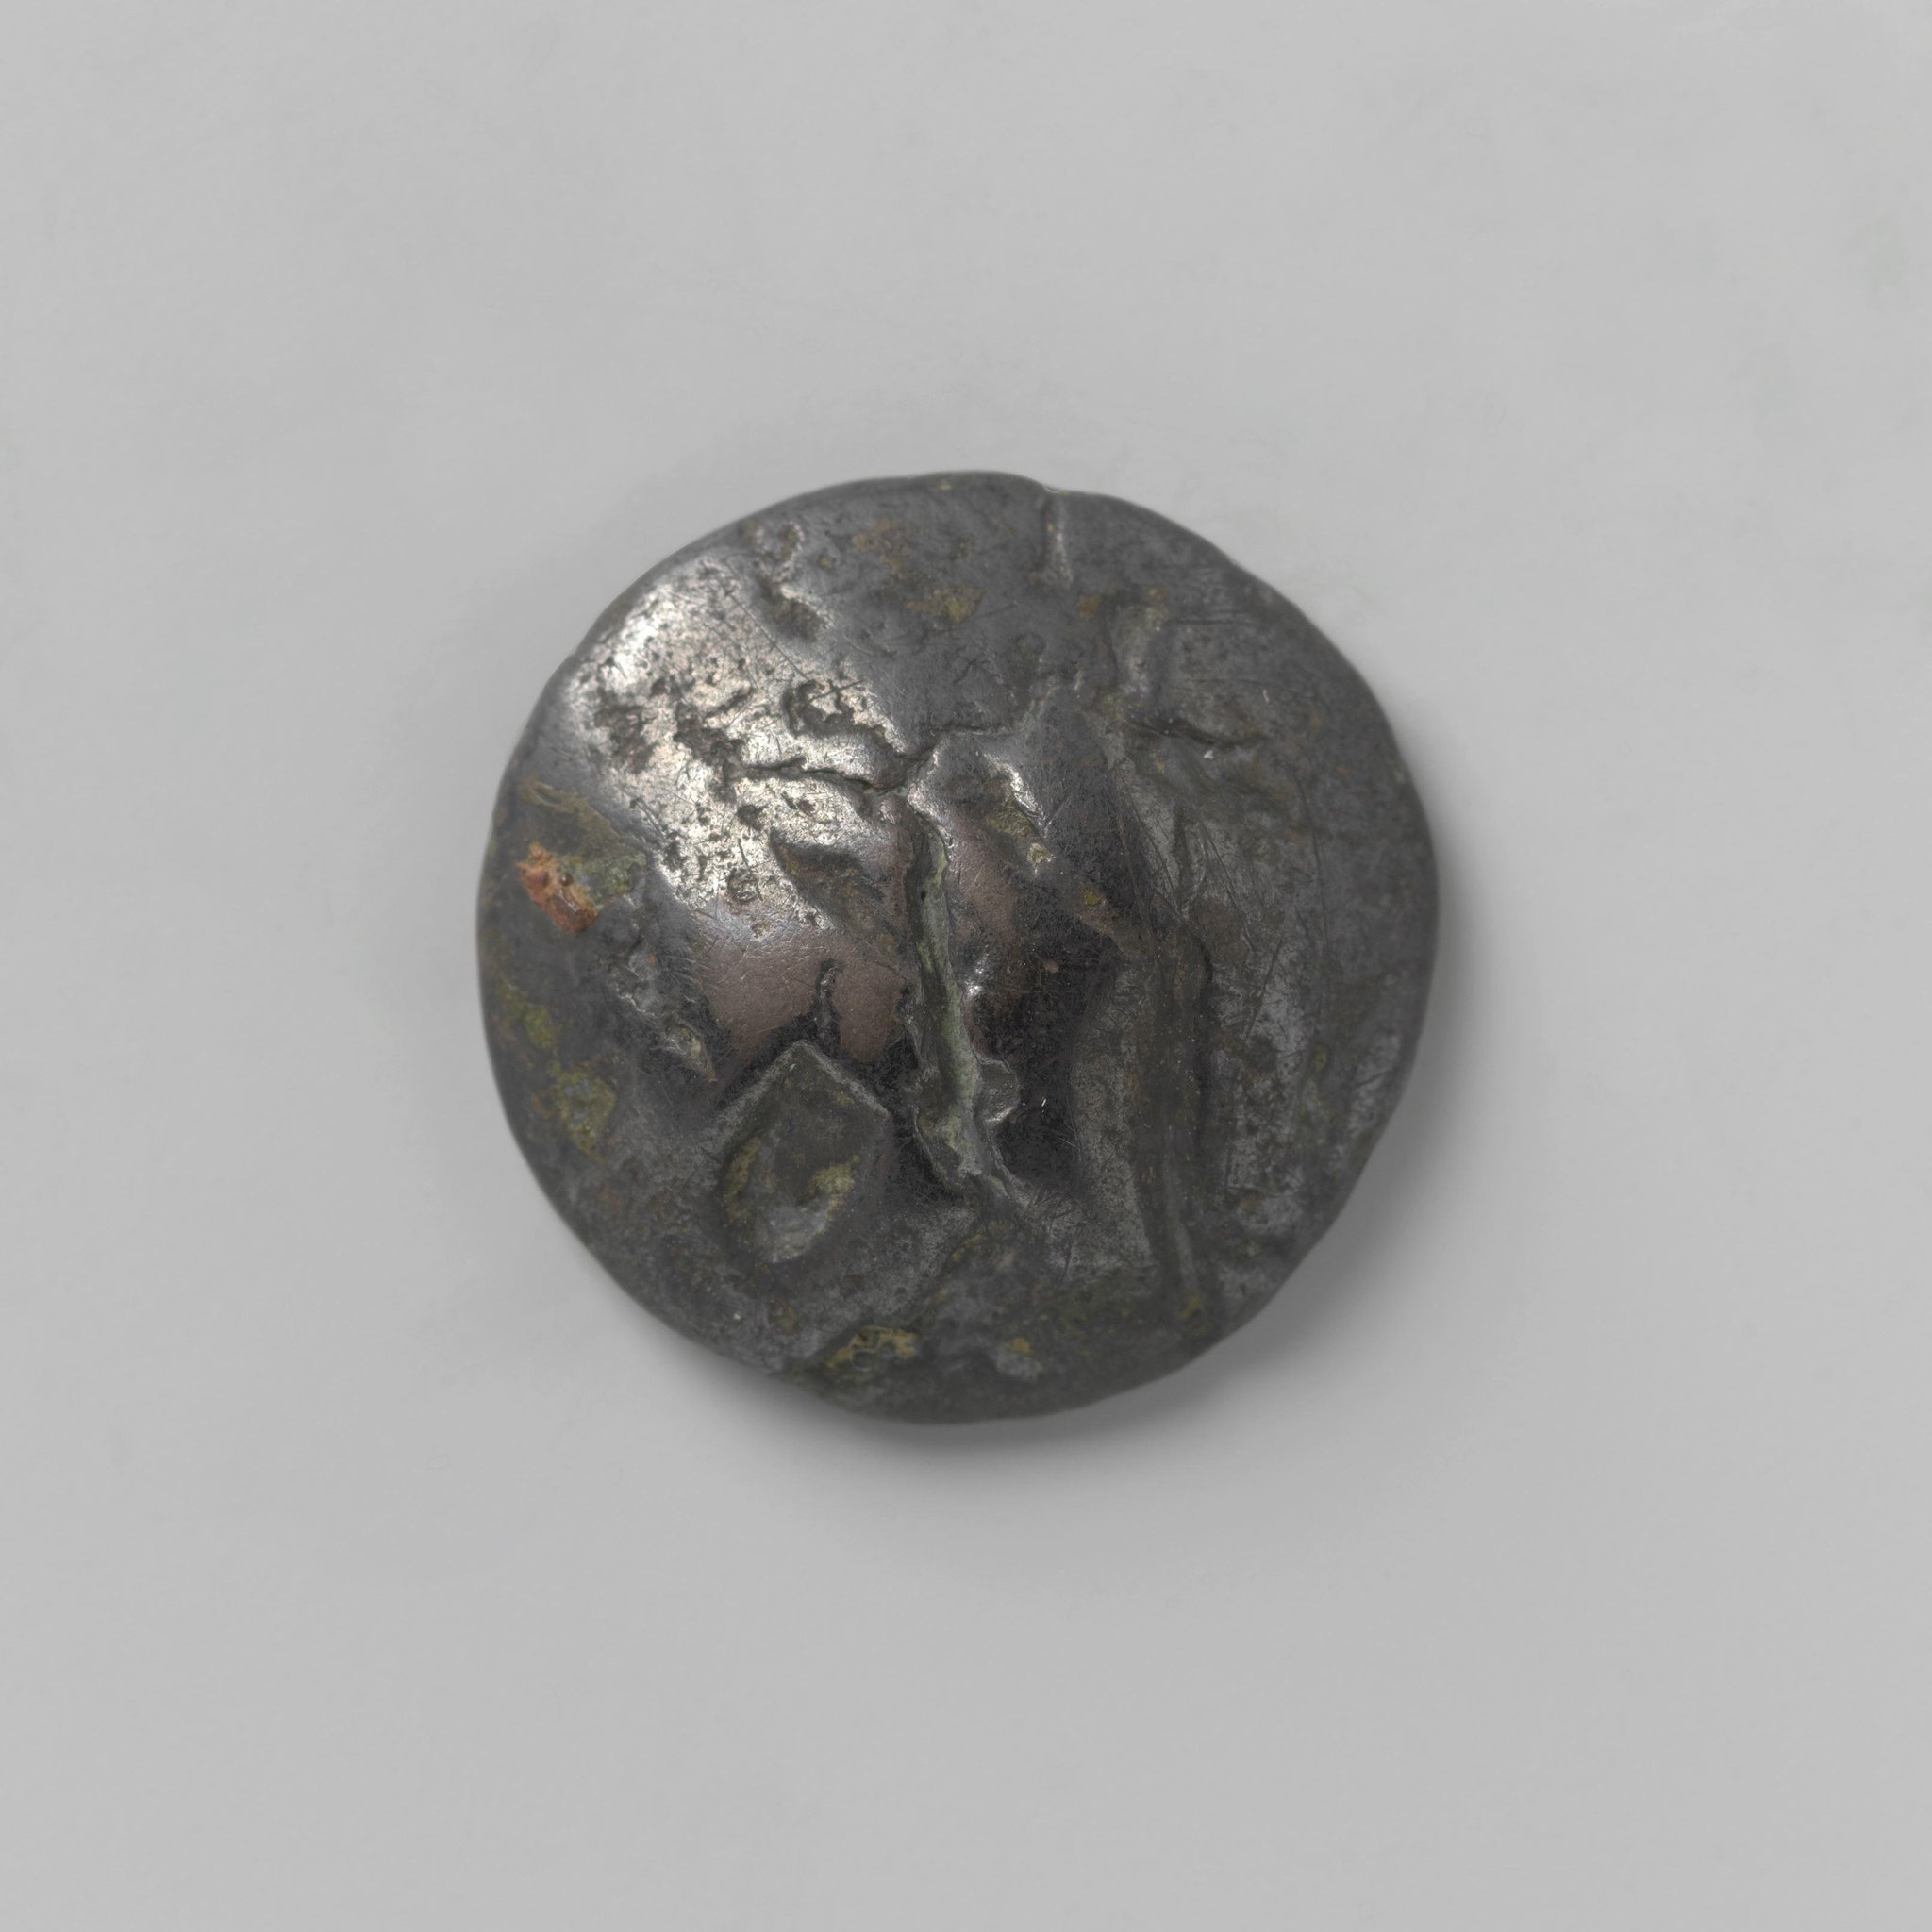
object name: coin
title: Java, koninkrijk[Majopahit, djampel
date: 1290-1520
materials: silver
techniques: striking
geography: java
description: Zilveren schotelvormige munt. Voorzijde: letterteken in devanagari-schrift [ma?]. Keerzijde, figuratie [bloem?].